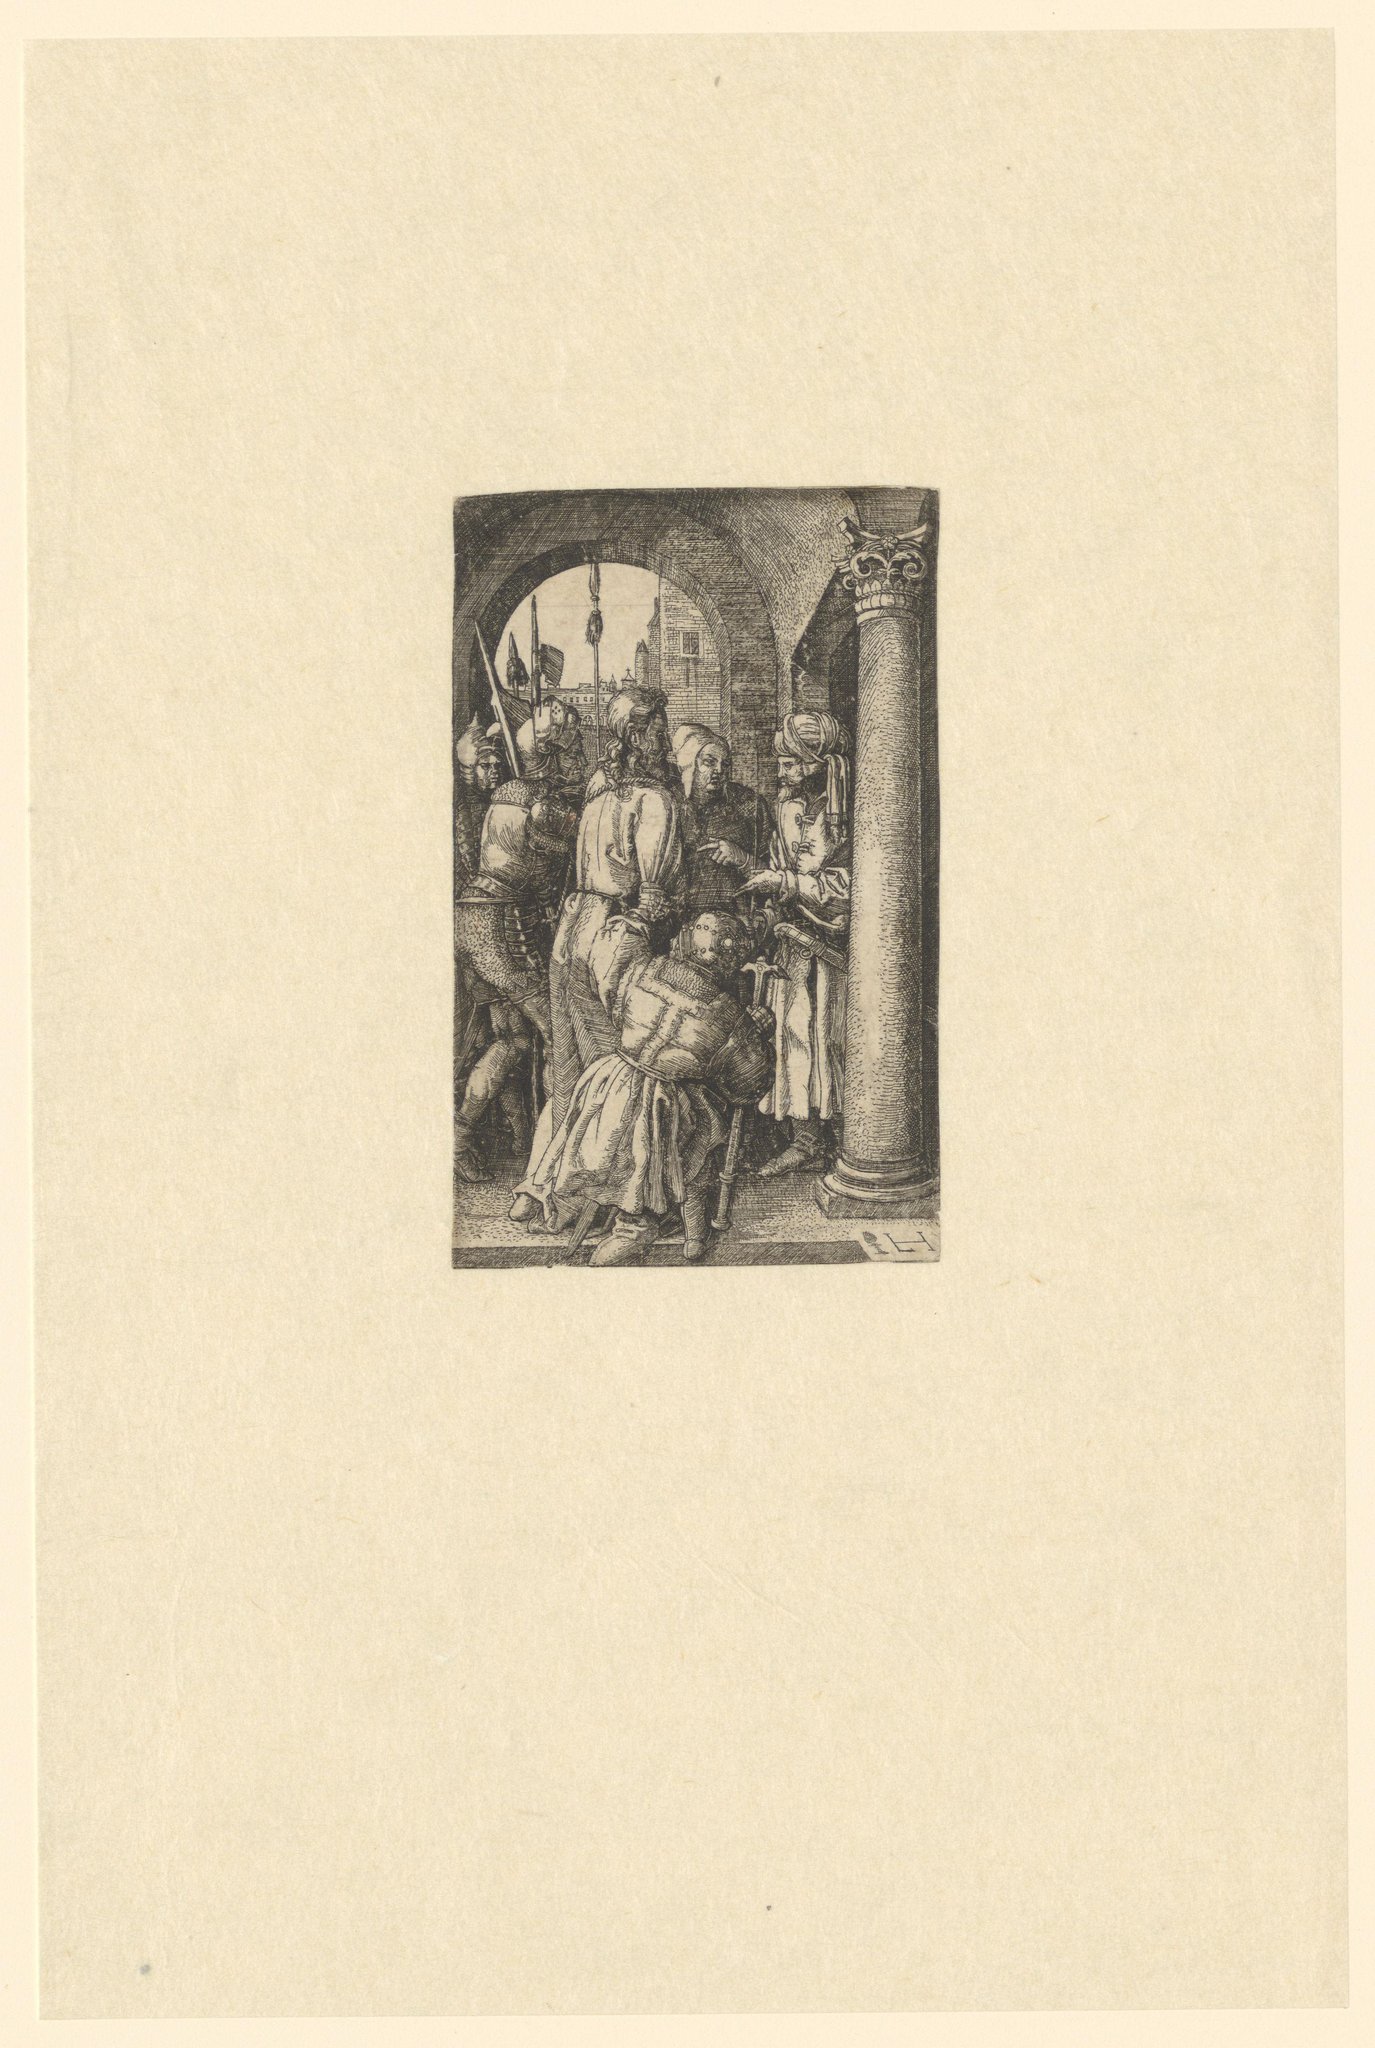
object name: print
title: Christus voor Pilatus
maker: lambert hopfer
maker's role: print maker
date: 1520-1530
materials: paper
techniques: etching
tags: christ before pontius pilate (matthew 27:11-26; mark 15:2-15; luke 23:2-7, 23:13-25; john 18:28 - 19:16)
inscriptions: collector's mark: Lugt 2228